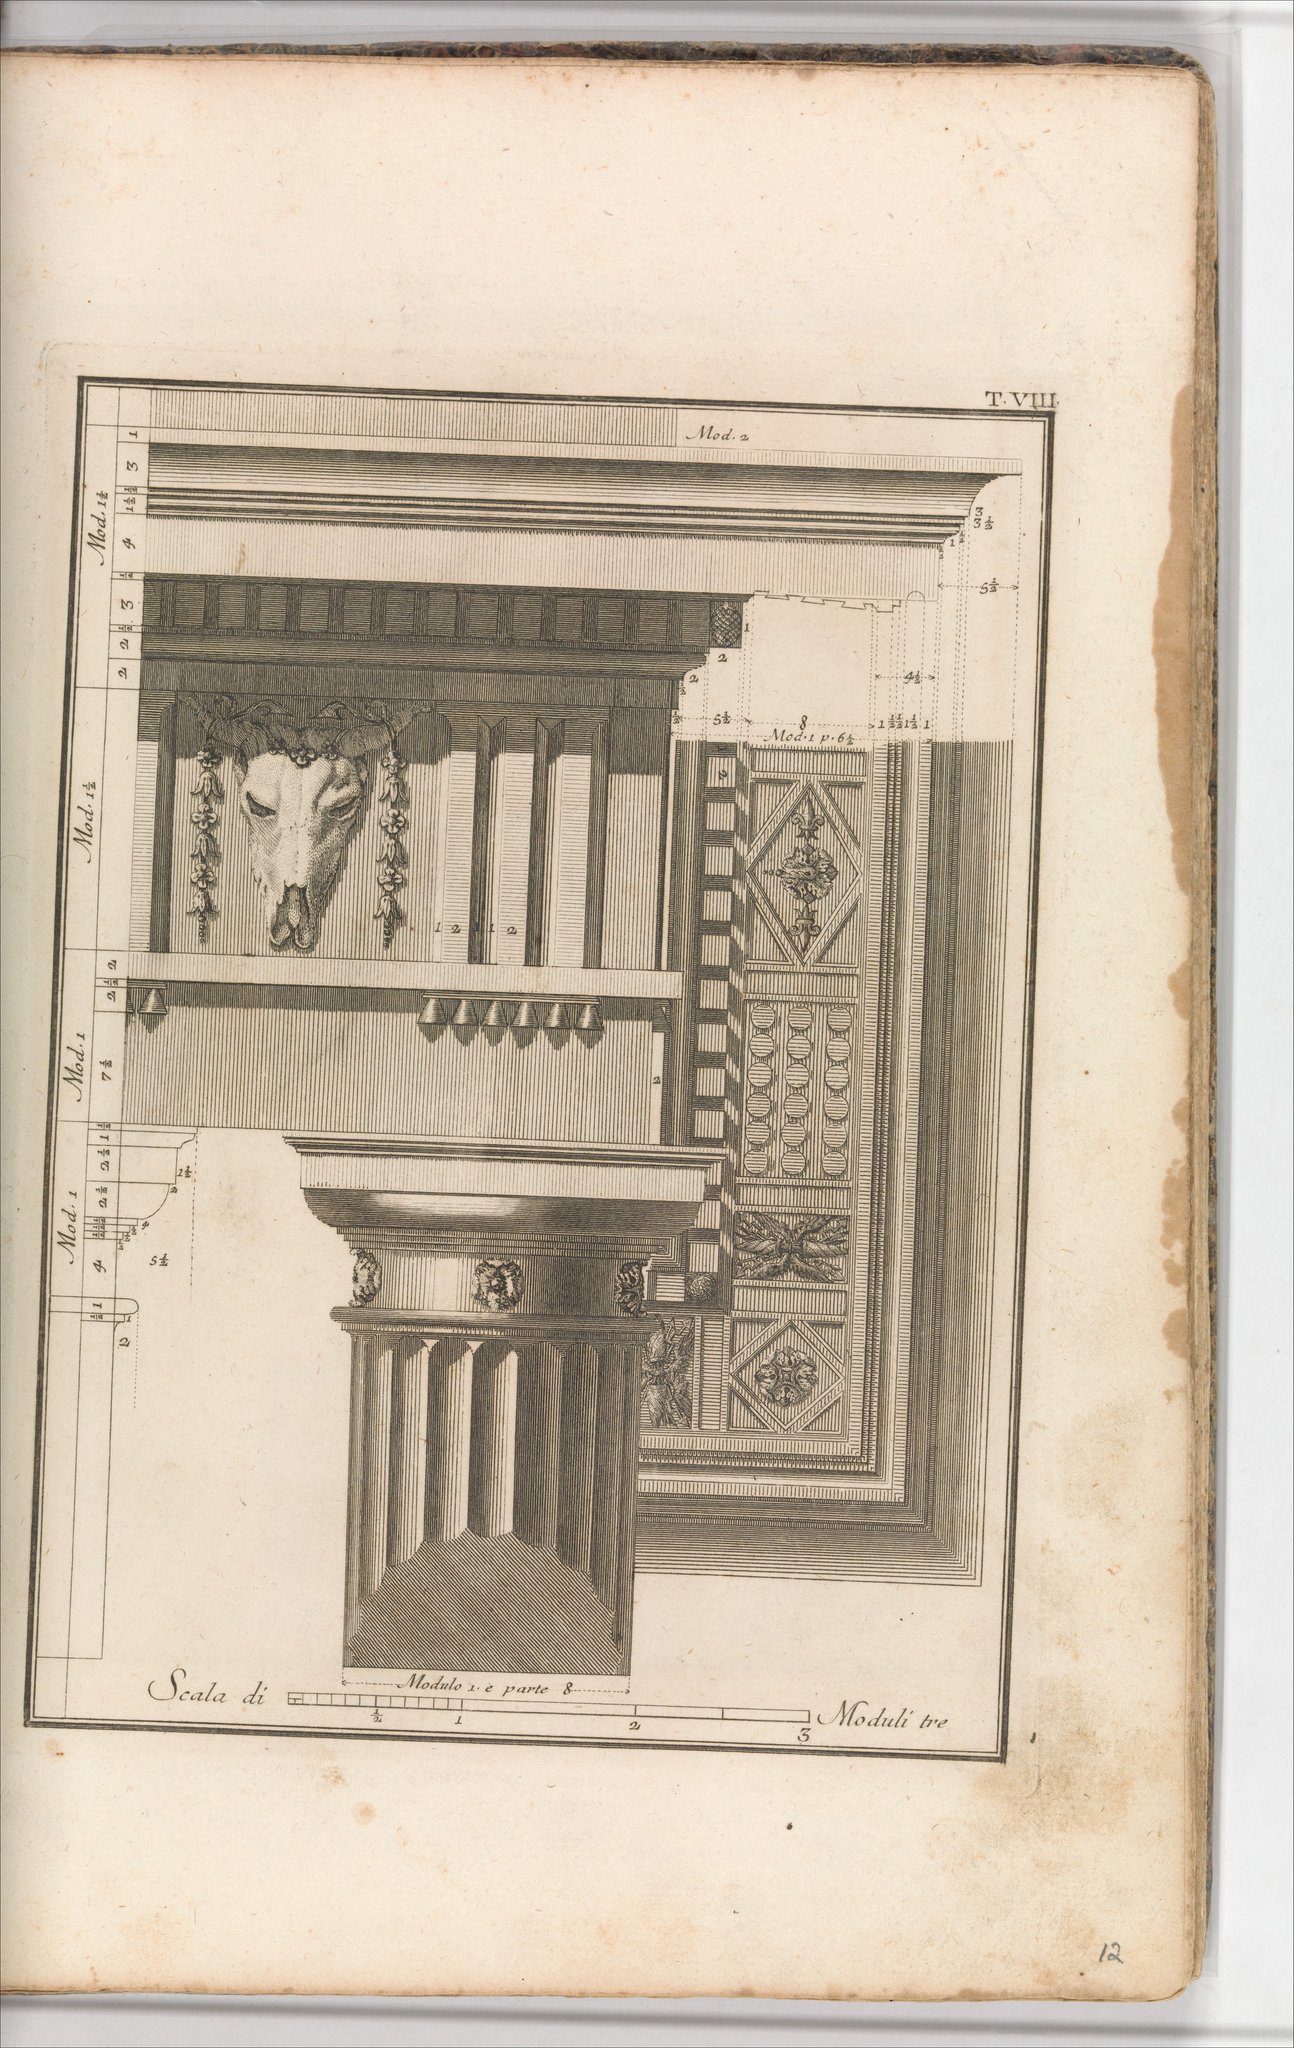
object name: book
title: Il Vignola Illustrato Proposto da Giambattista Spampani, e Carlo Antonini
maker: jacopo [giacomo] barozzi da vignola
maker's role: author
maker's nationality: italian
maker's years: 1507-1573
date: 1770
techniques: engraving, printing, woodcut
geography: italy